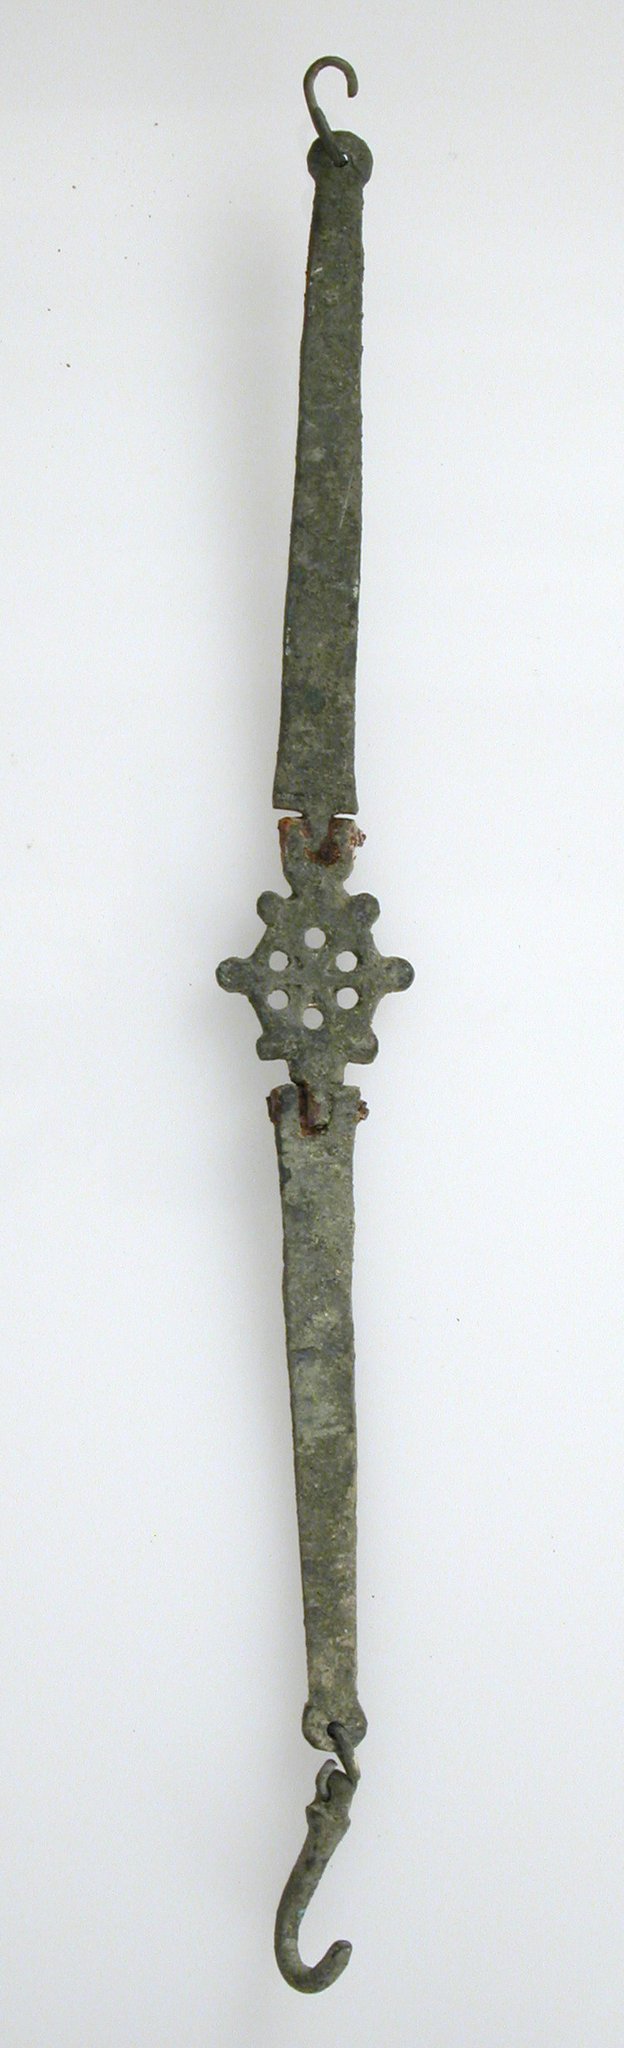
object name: hanging strap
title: Suspension Strap for Polycandelon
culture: byzantine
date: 401-433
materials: copper alloy